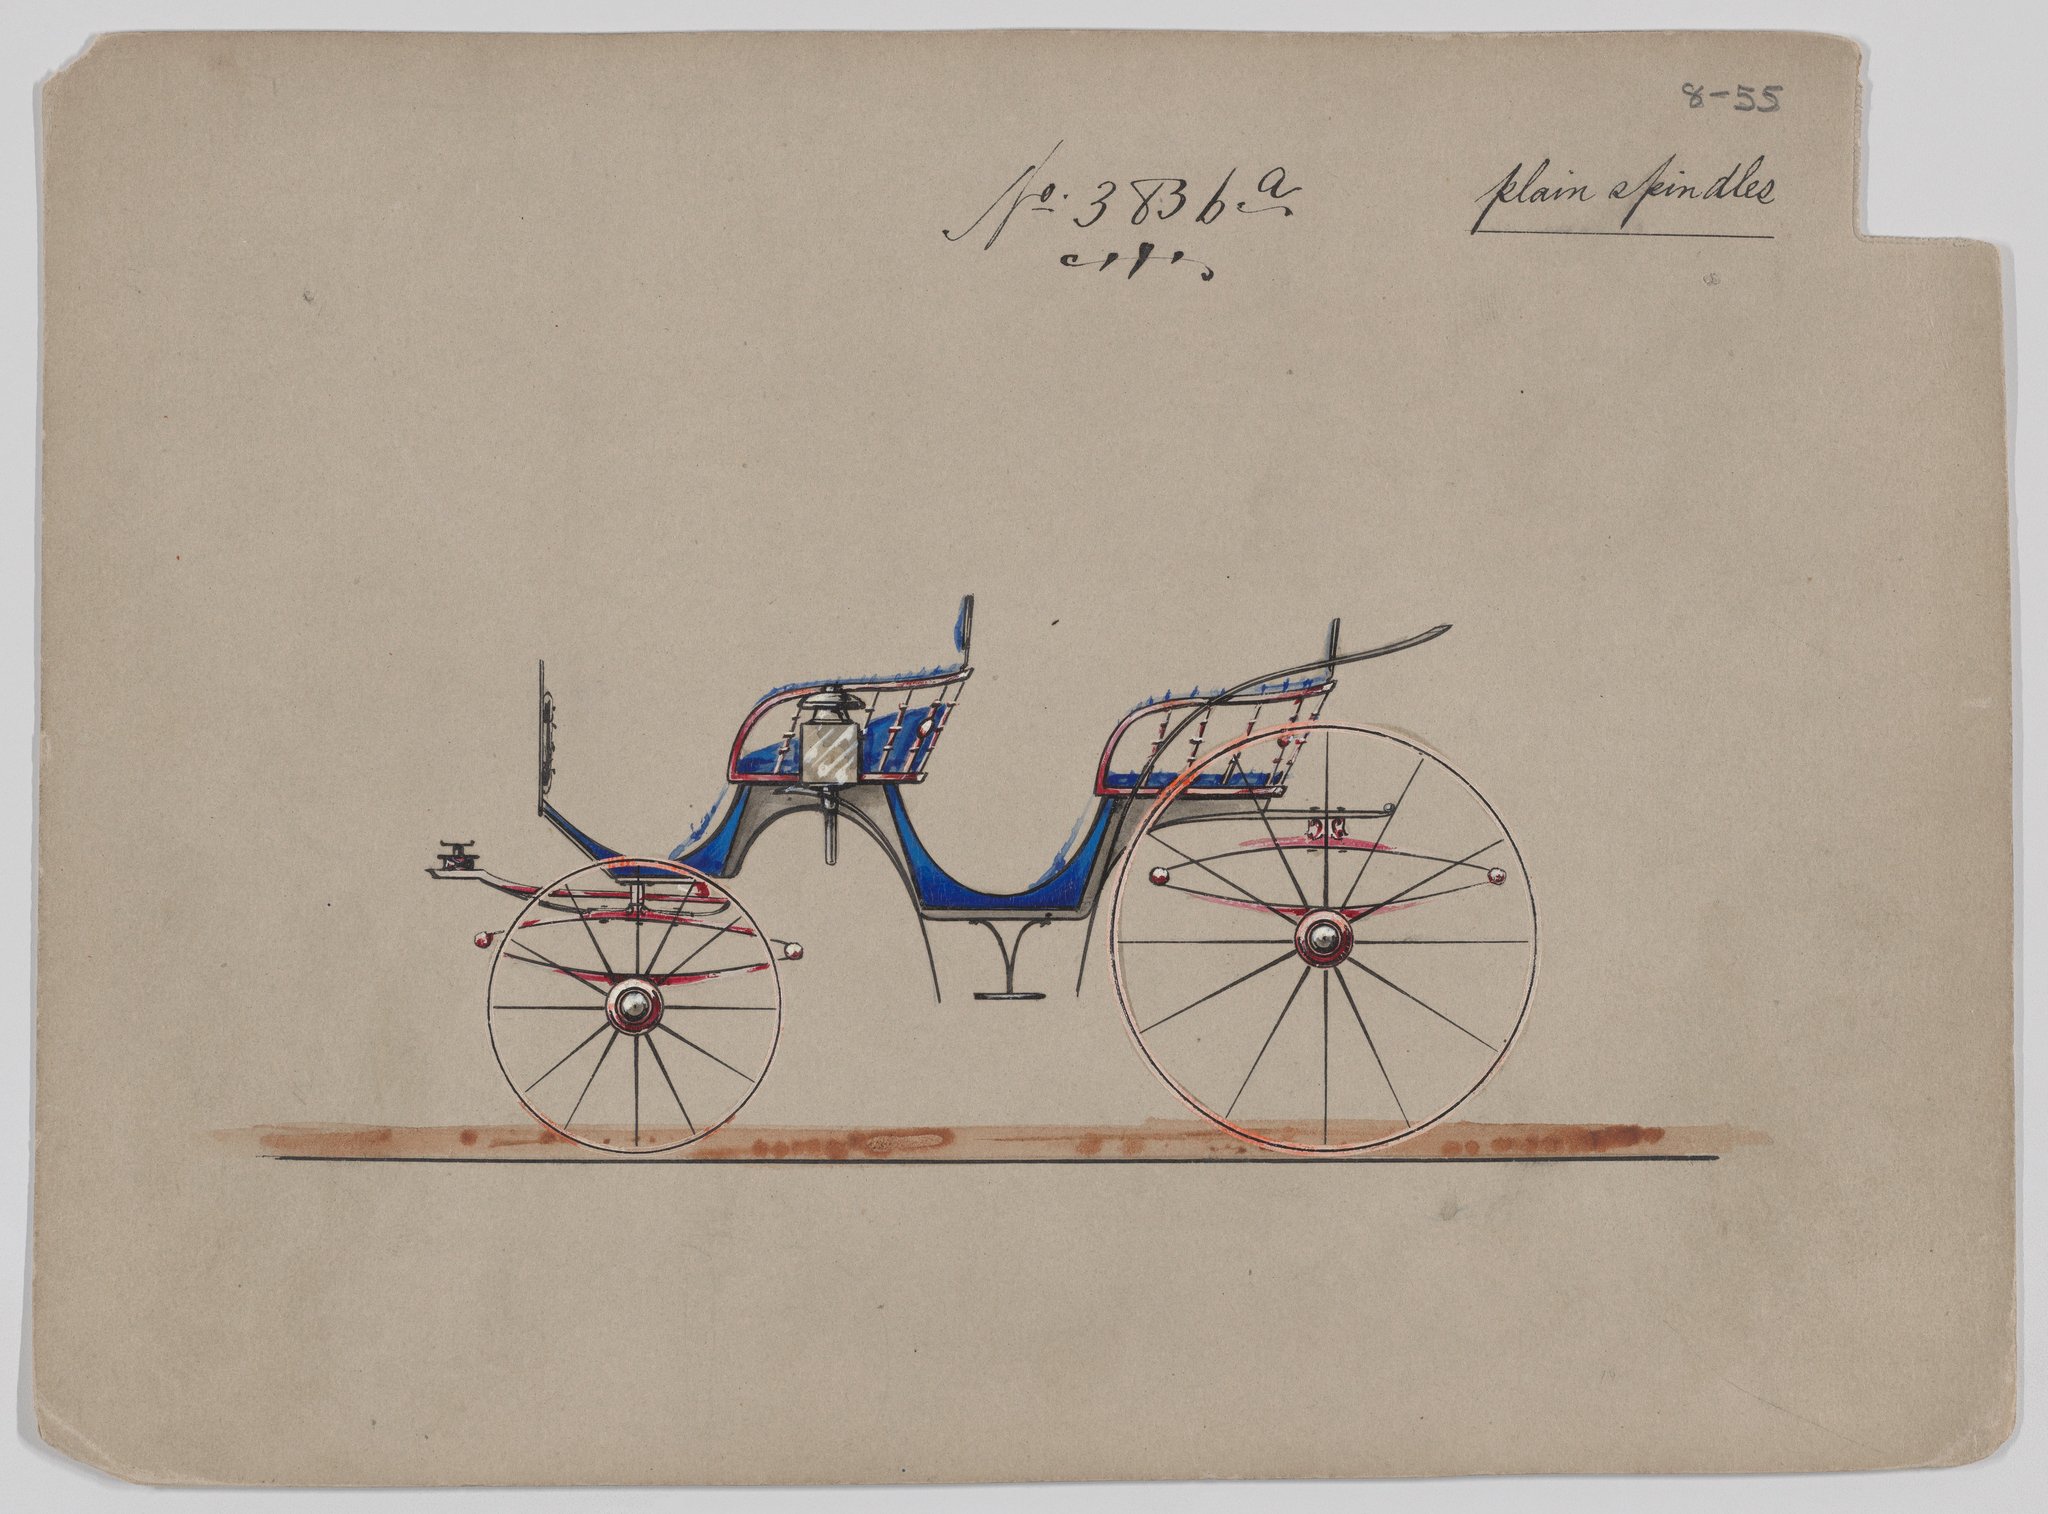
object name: drawing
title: Design for 4 seat Phaeton, no top, no. 3836a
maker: brewster & co.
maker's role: manufacturer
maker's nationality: american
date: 1883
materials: gouache, gum arabic, ink, watercolor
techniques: pen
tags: carriages